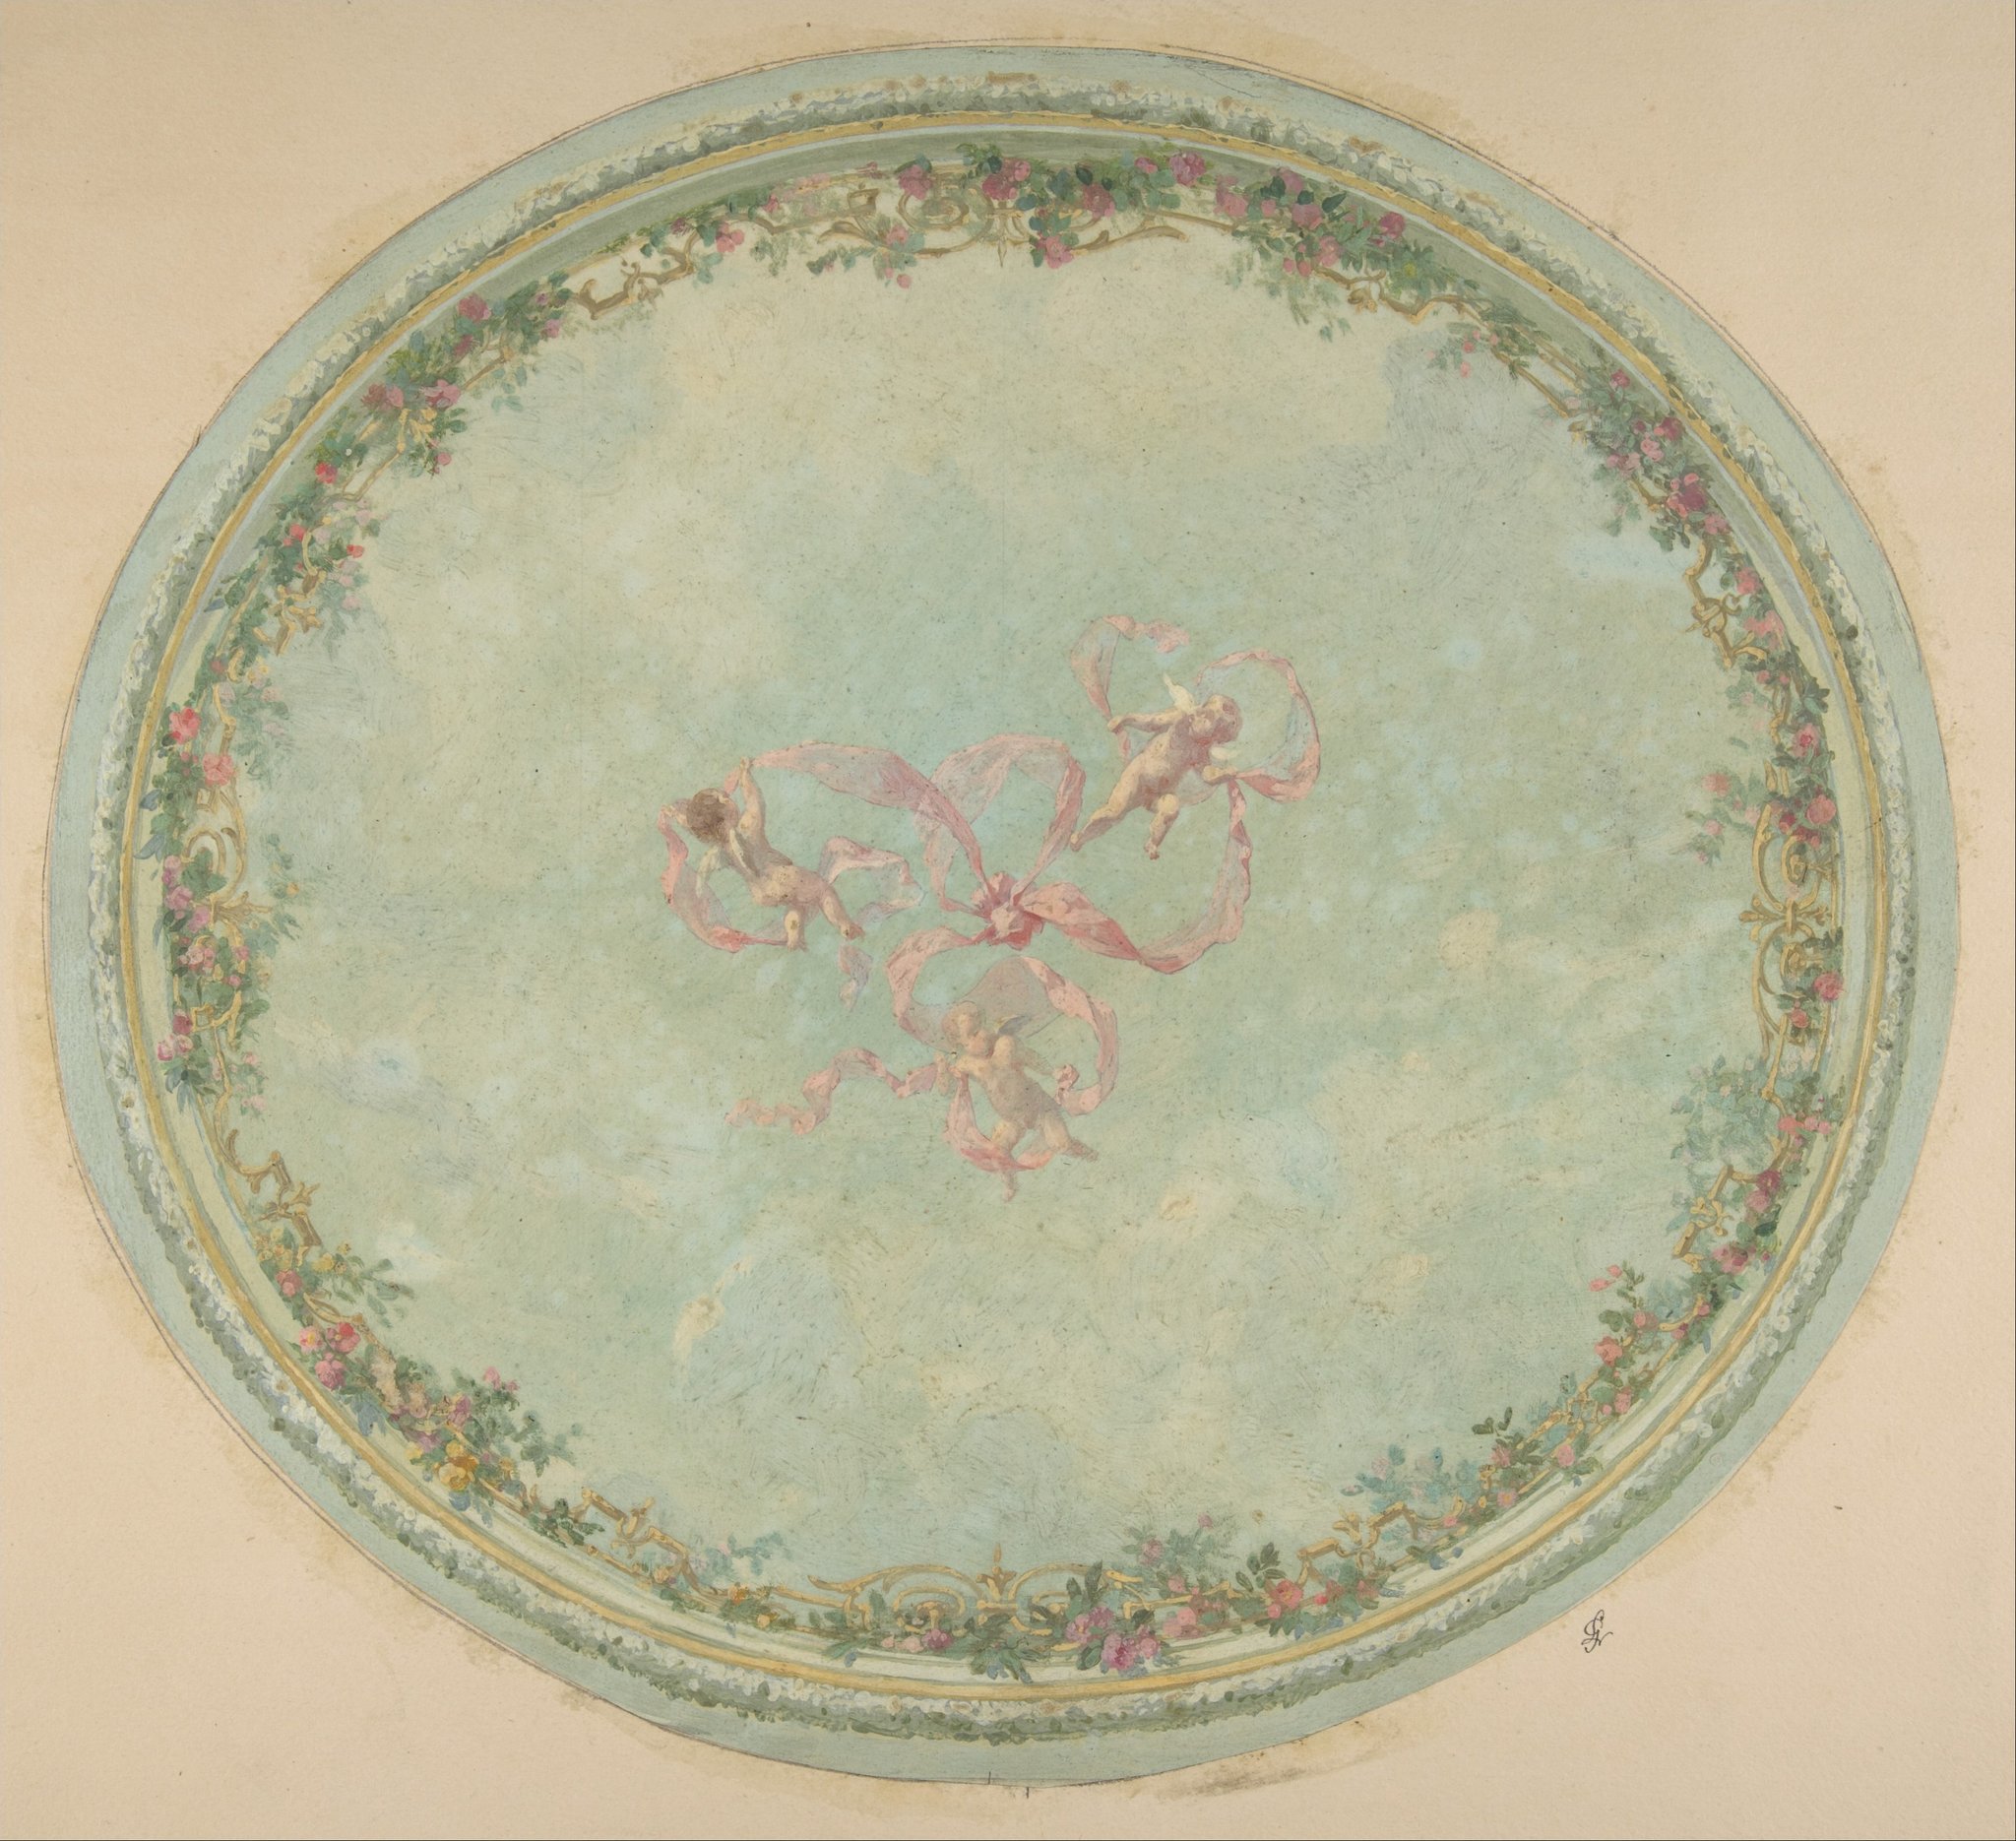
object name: drawing ornament architecture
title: Ceiling Design for the Pless Chateau, Silesia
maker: jules-edmond-charles lachaise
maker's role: artist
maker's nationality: french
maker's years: 1897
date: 1851-1900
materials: gouache